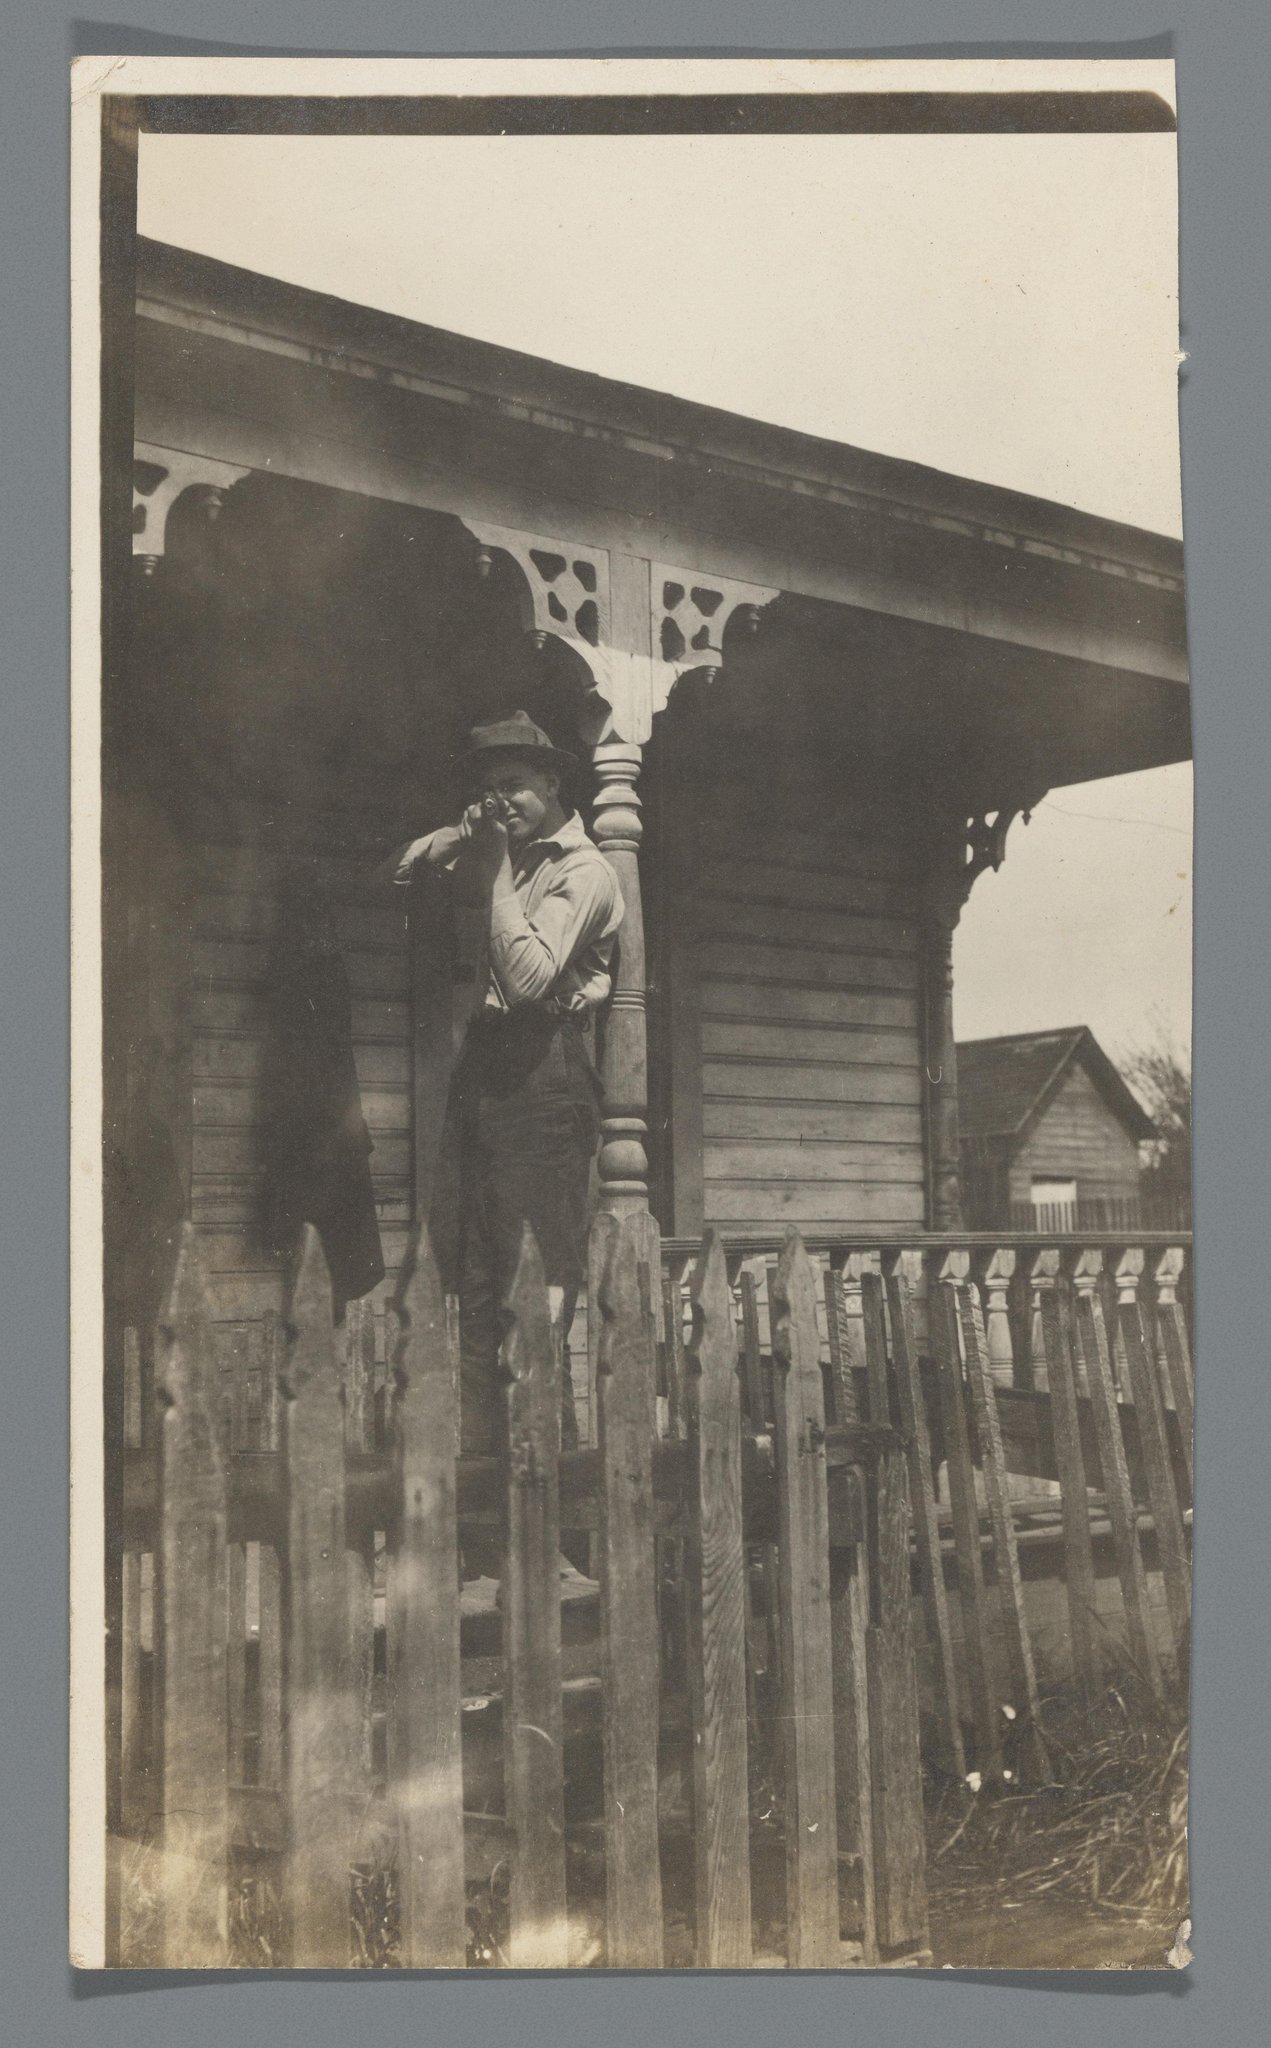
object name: photograph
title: Man (Mike Patterson) op veranda die een geweer richt op de fotograaf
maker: Anonymous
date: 1932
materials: paper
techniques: gelatin silver print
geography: united states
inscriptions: inscription: ‘1932/ “DEAD EYE” Mike/ Patterson’